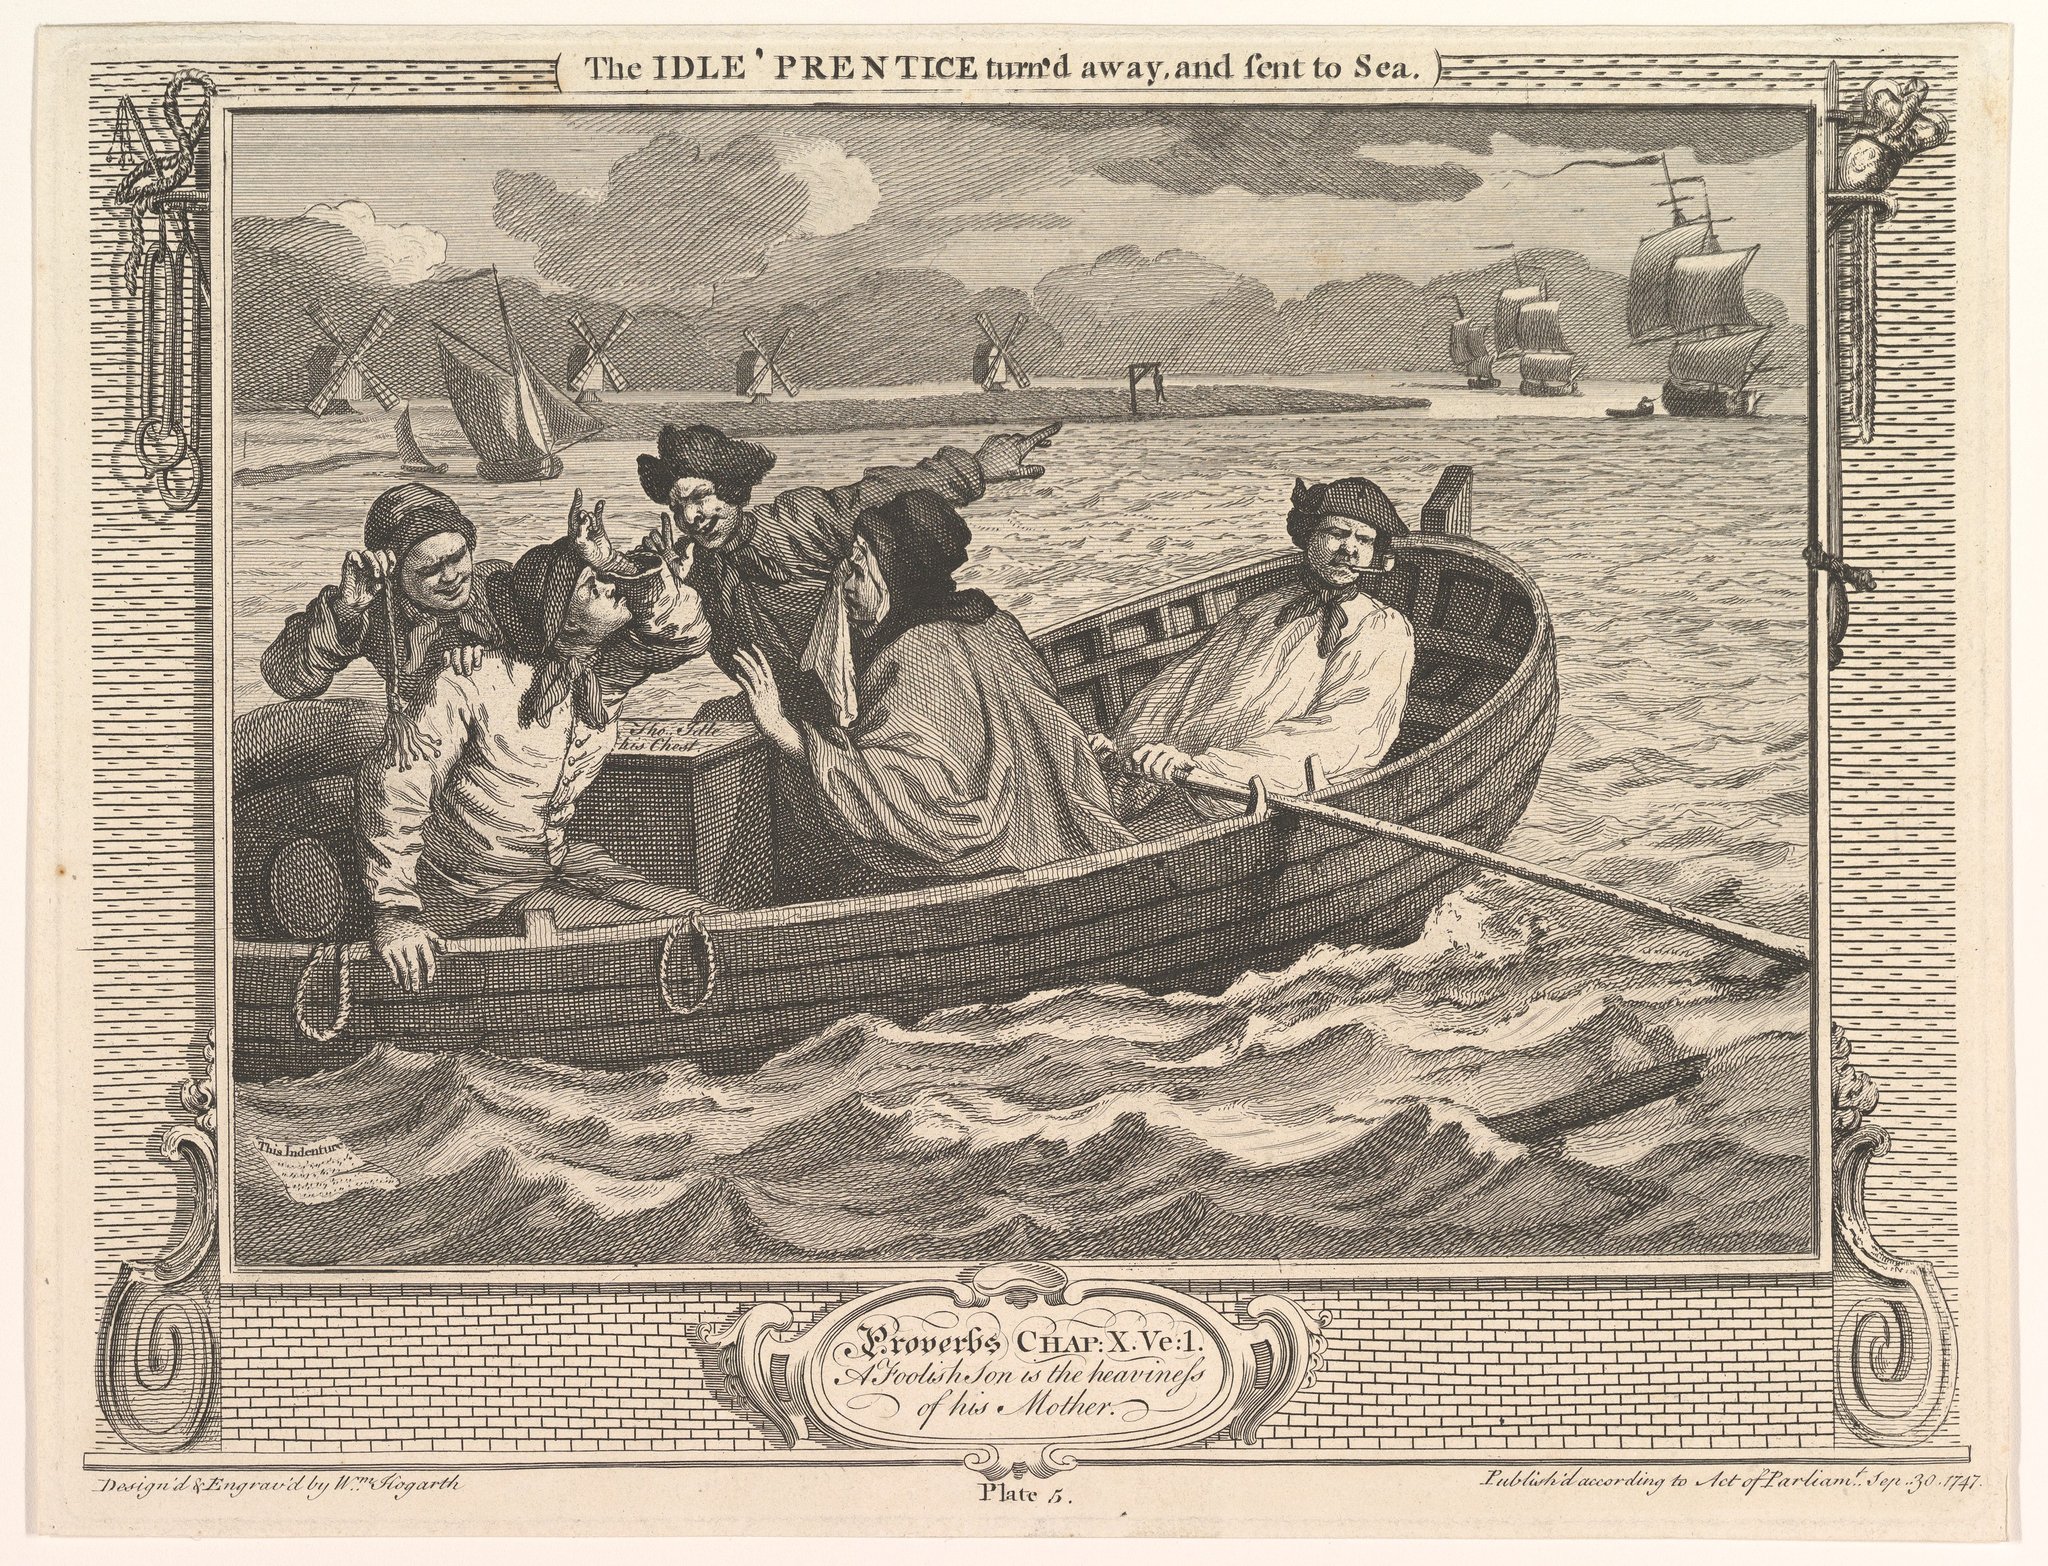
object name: print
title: The Idle 'Prentice Turned Away and Sent to Sea (Industry and Idleness, plate 5)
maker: william hogarth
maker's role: artist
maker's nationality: british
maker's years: 1697-1764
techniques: engraving, etching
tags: satire,men,boats